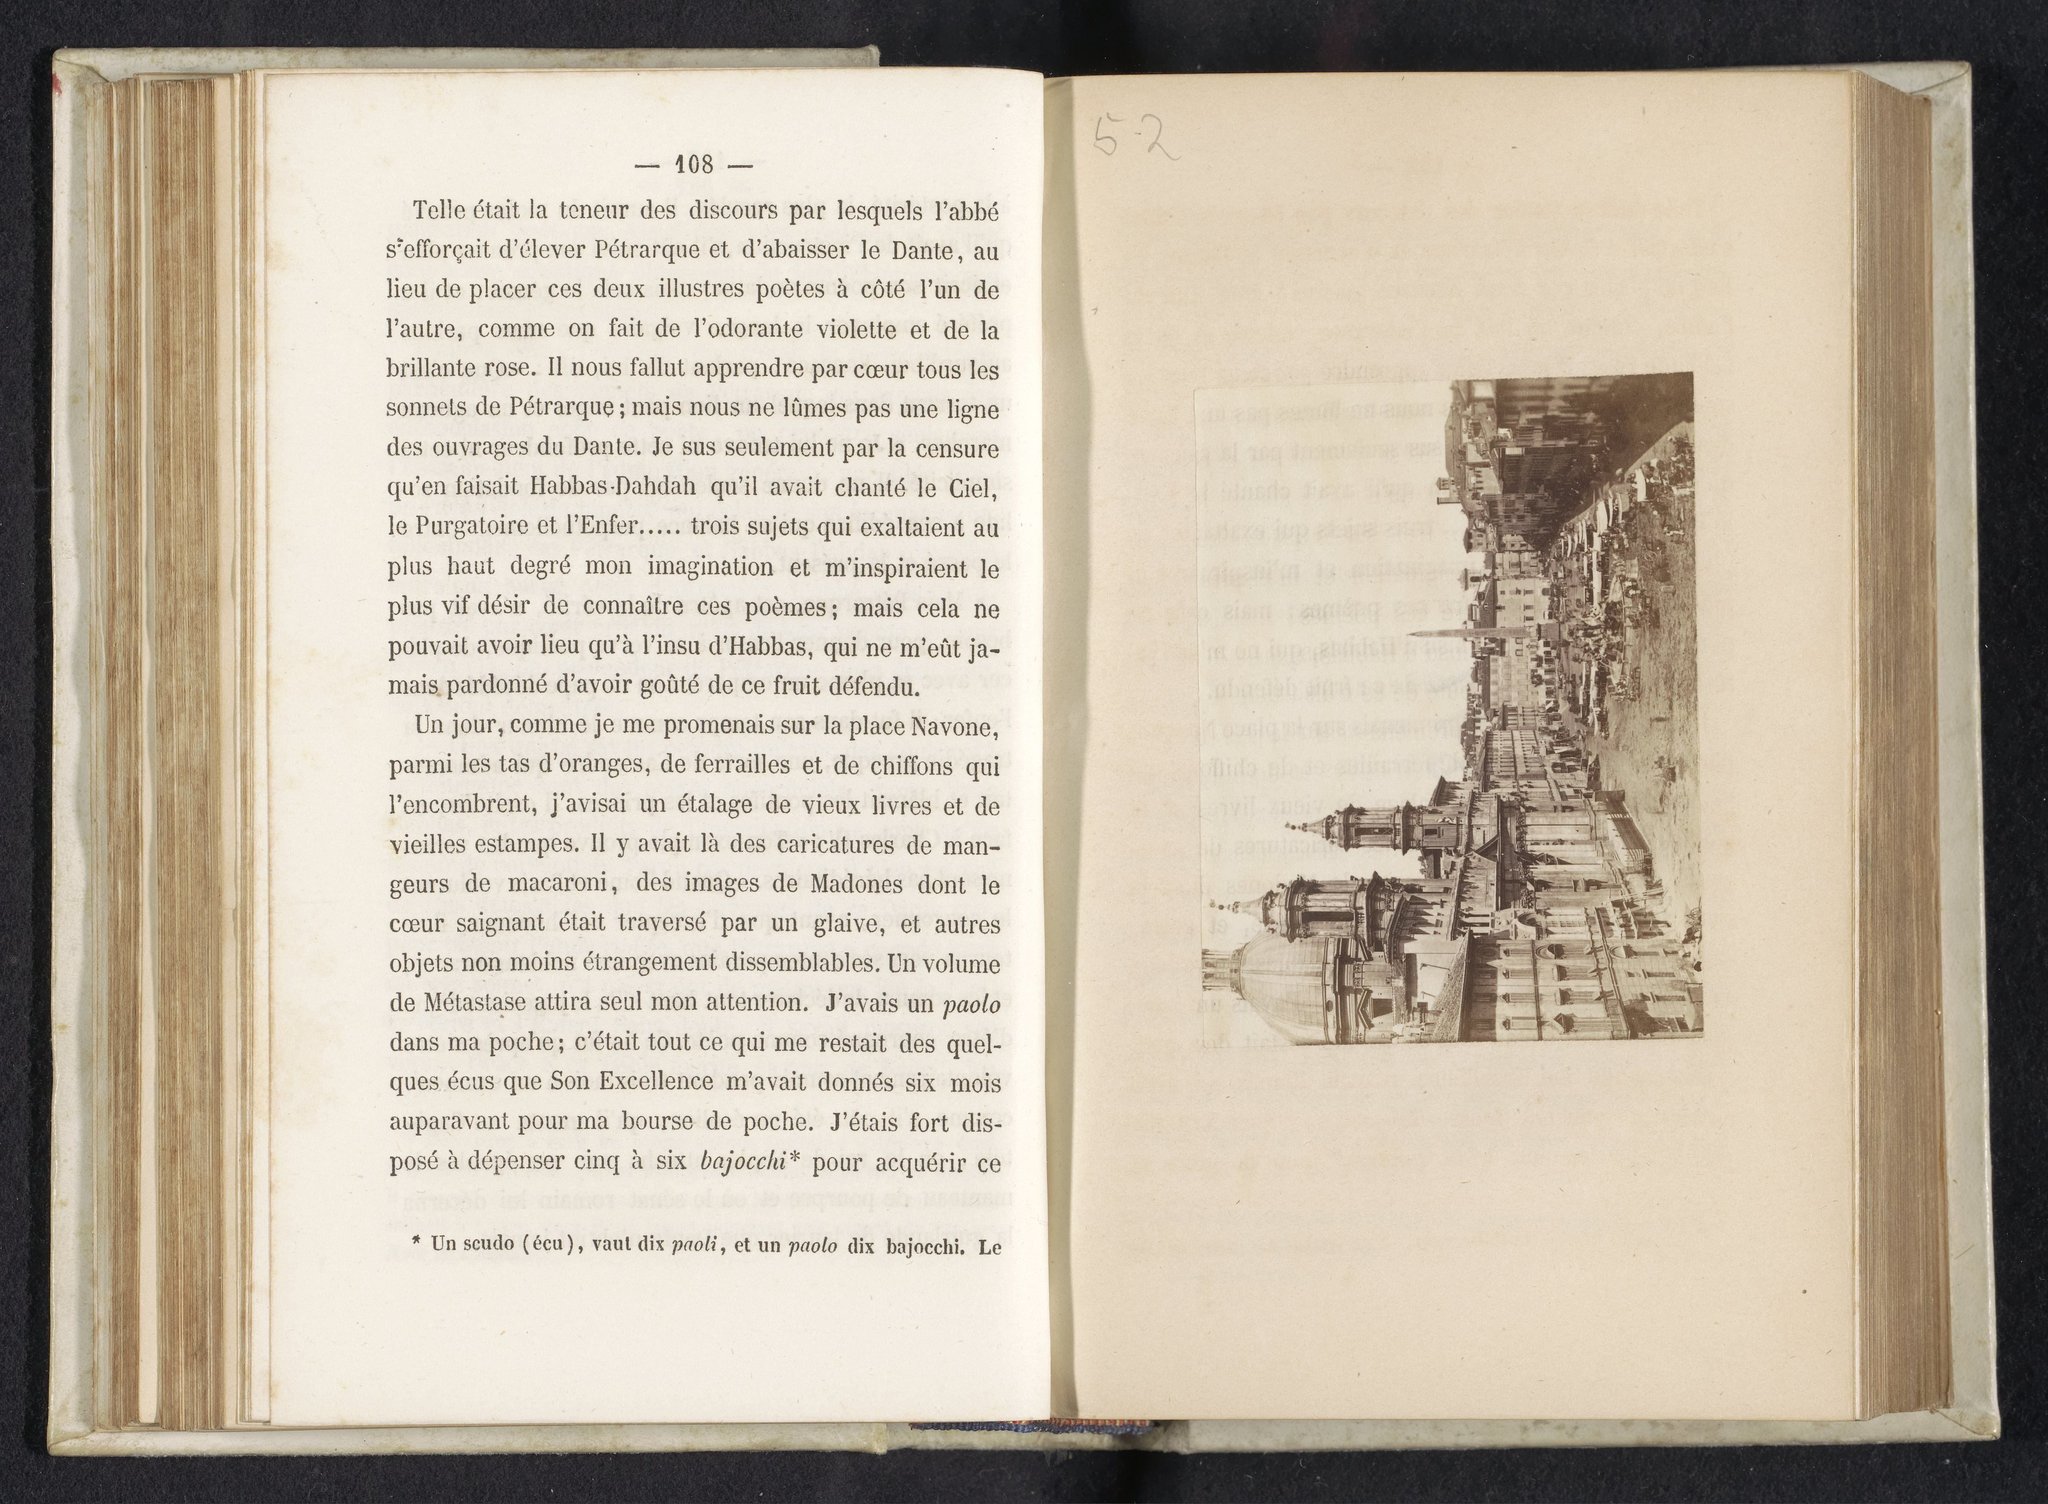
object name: page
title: Gezicht op het Piazza Navona te Rome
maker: Anonymous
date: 1850-1860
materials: photographic support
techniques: albumen print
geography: piazza navona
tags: square, place, circus, etc., obelisk, needle